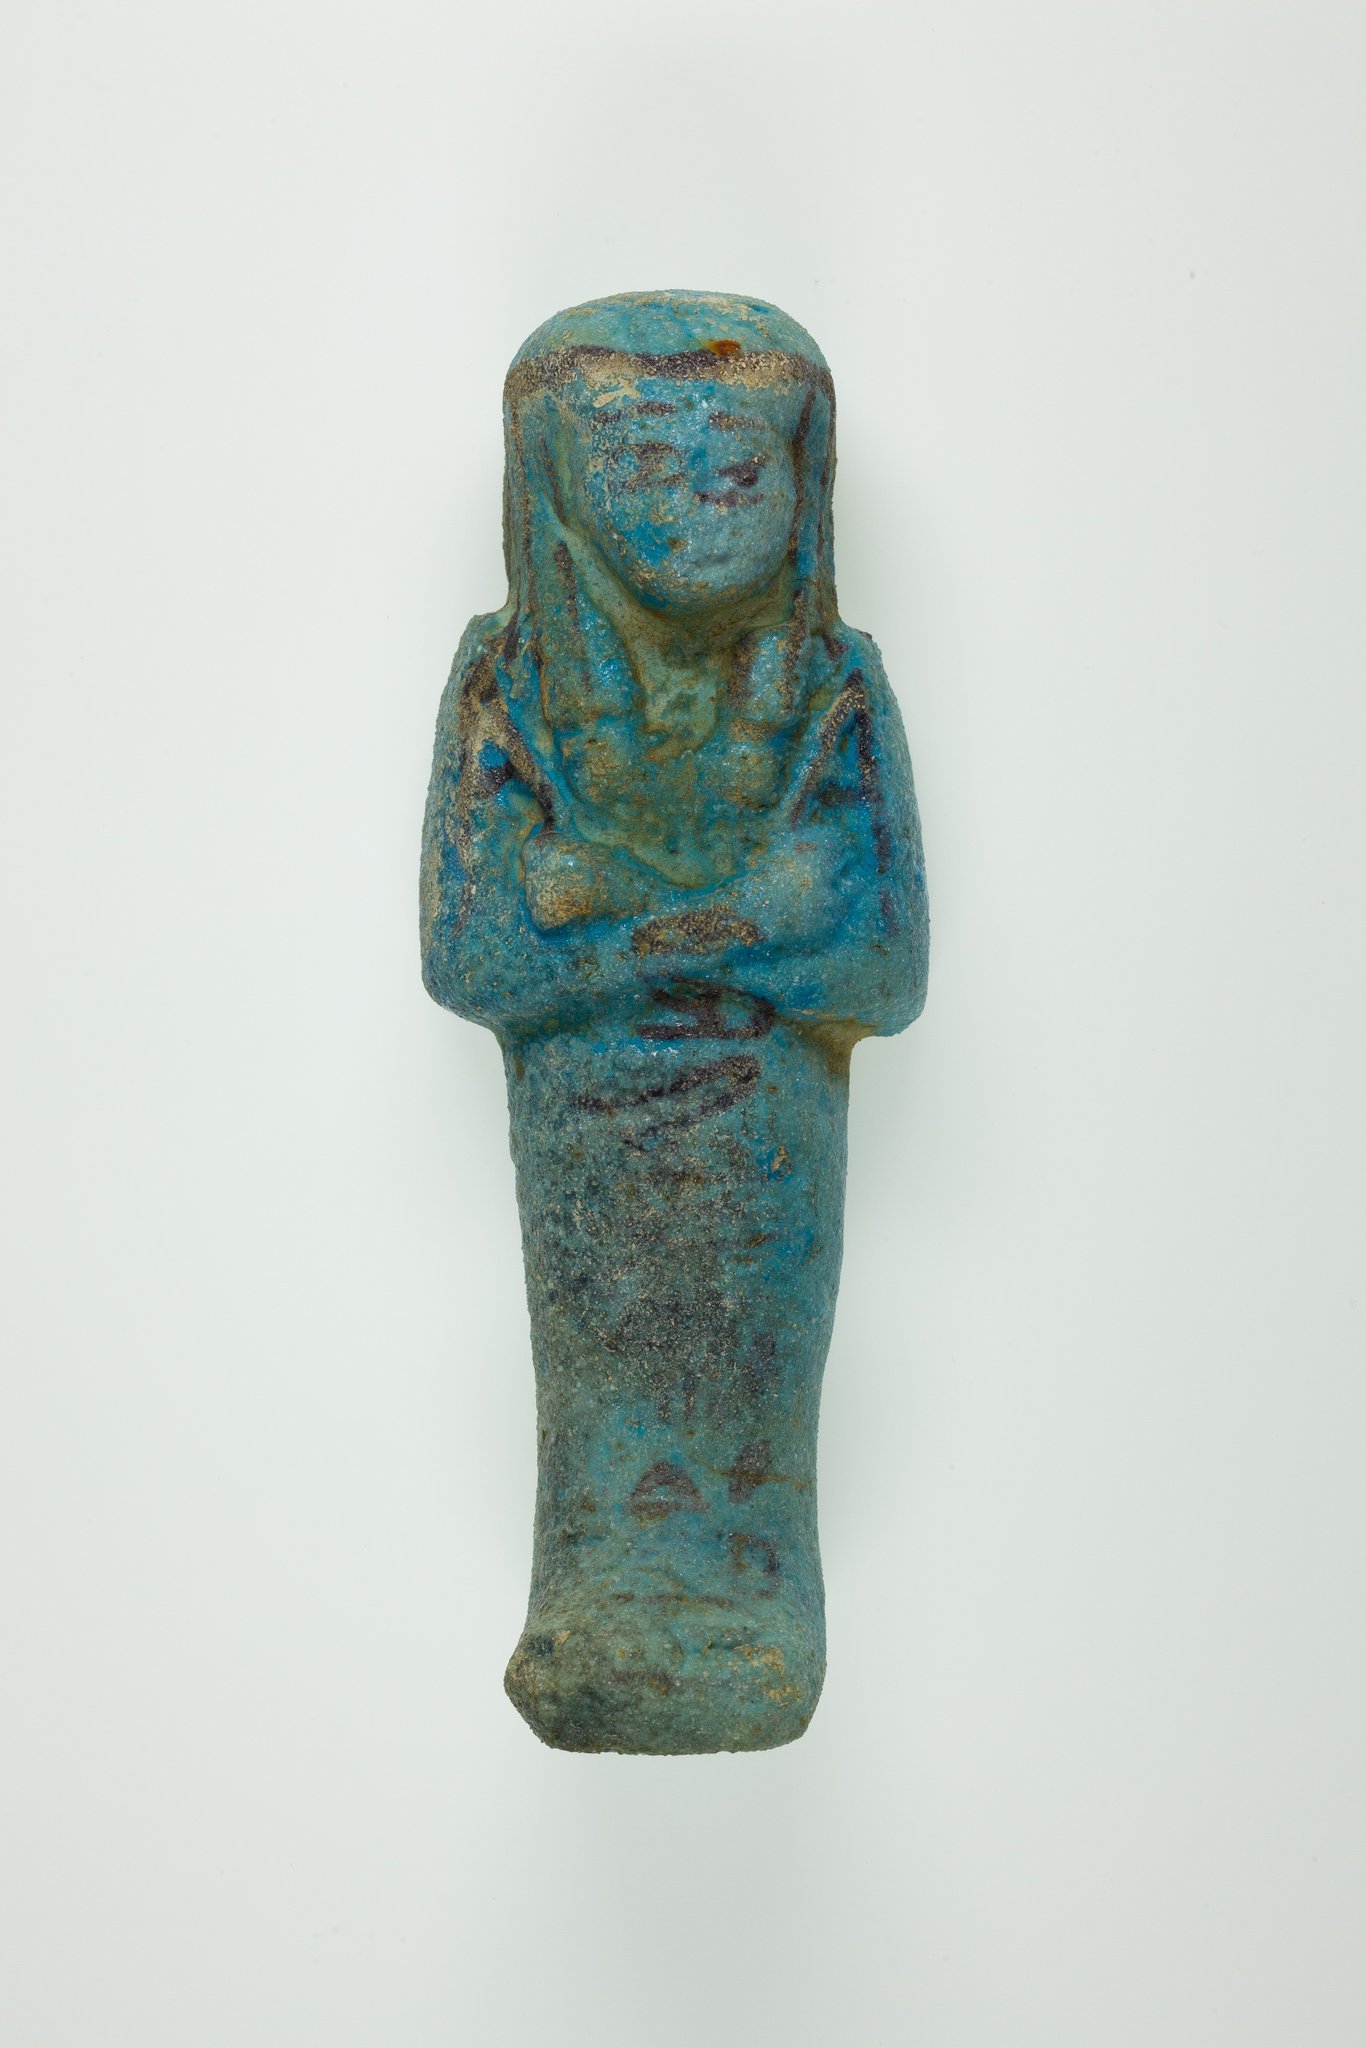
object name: shabti, henettawy c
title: Worker Shabti of Henettawy (C), Daughter of Isetemkheb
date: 990-970 BCE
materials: faience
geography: egypt